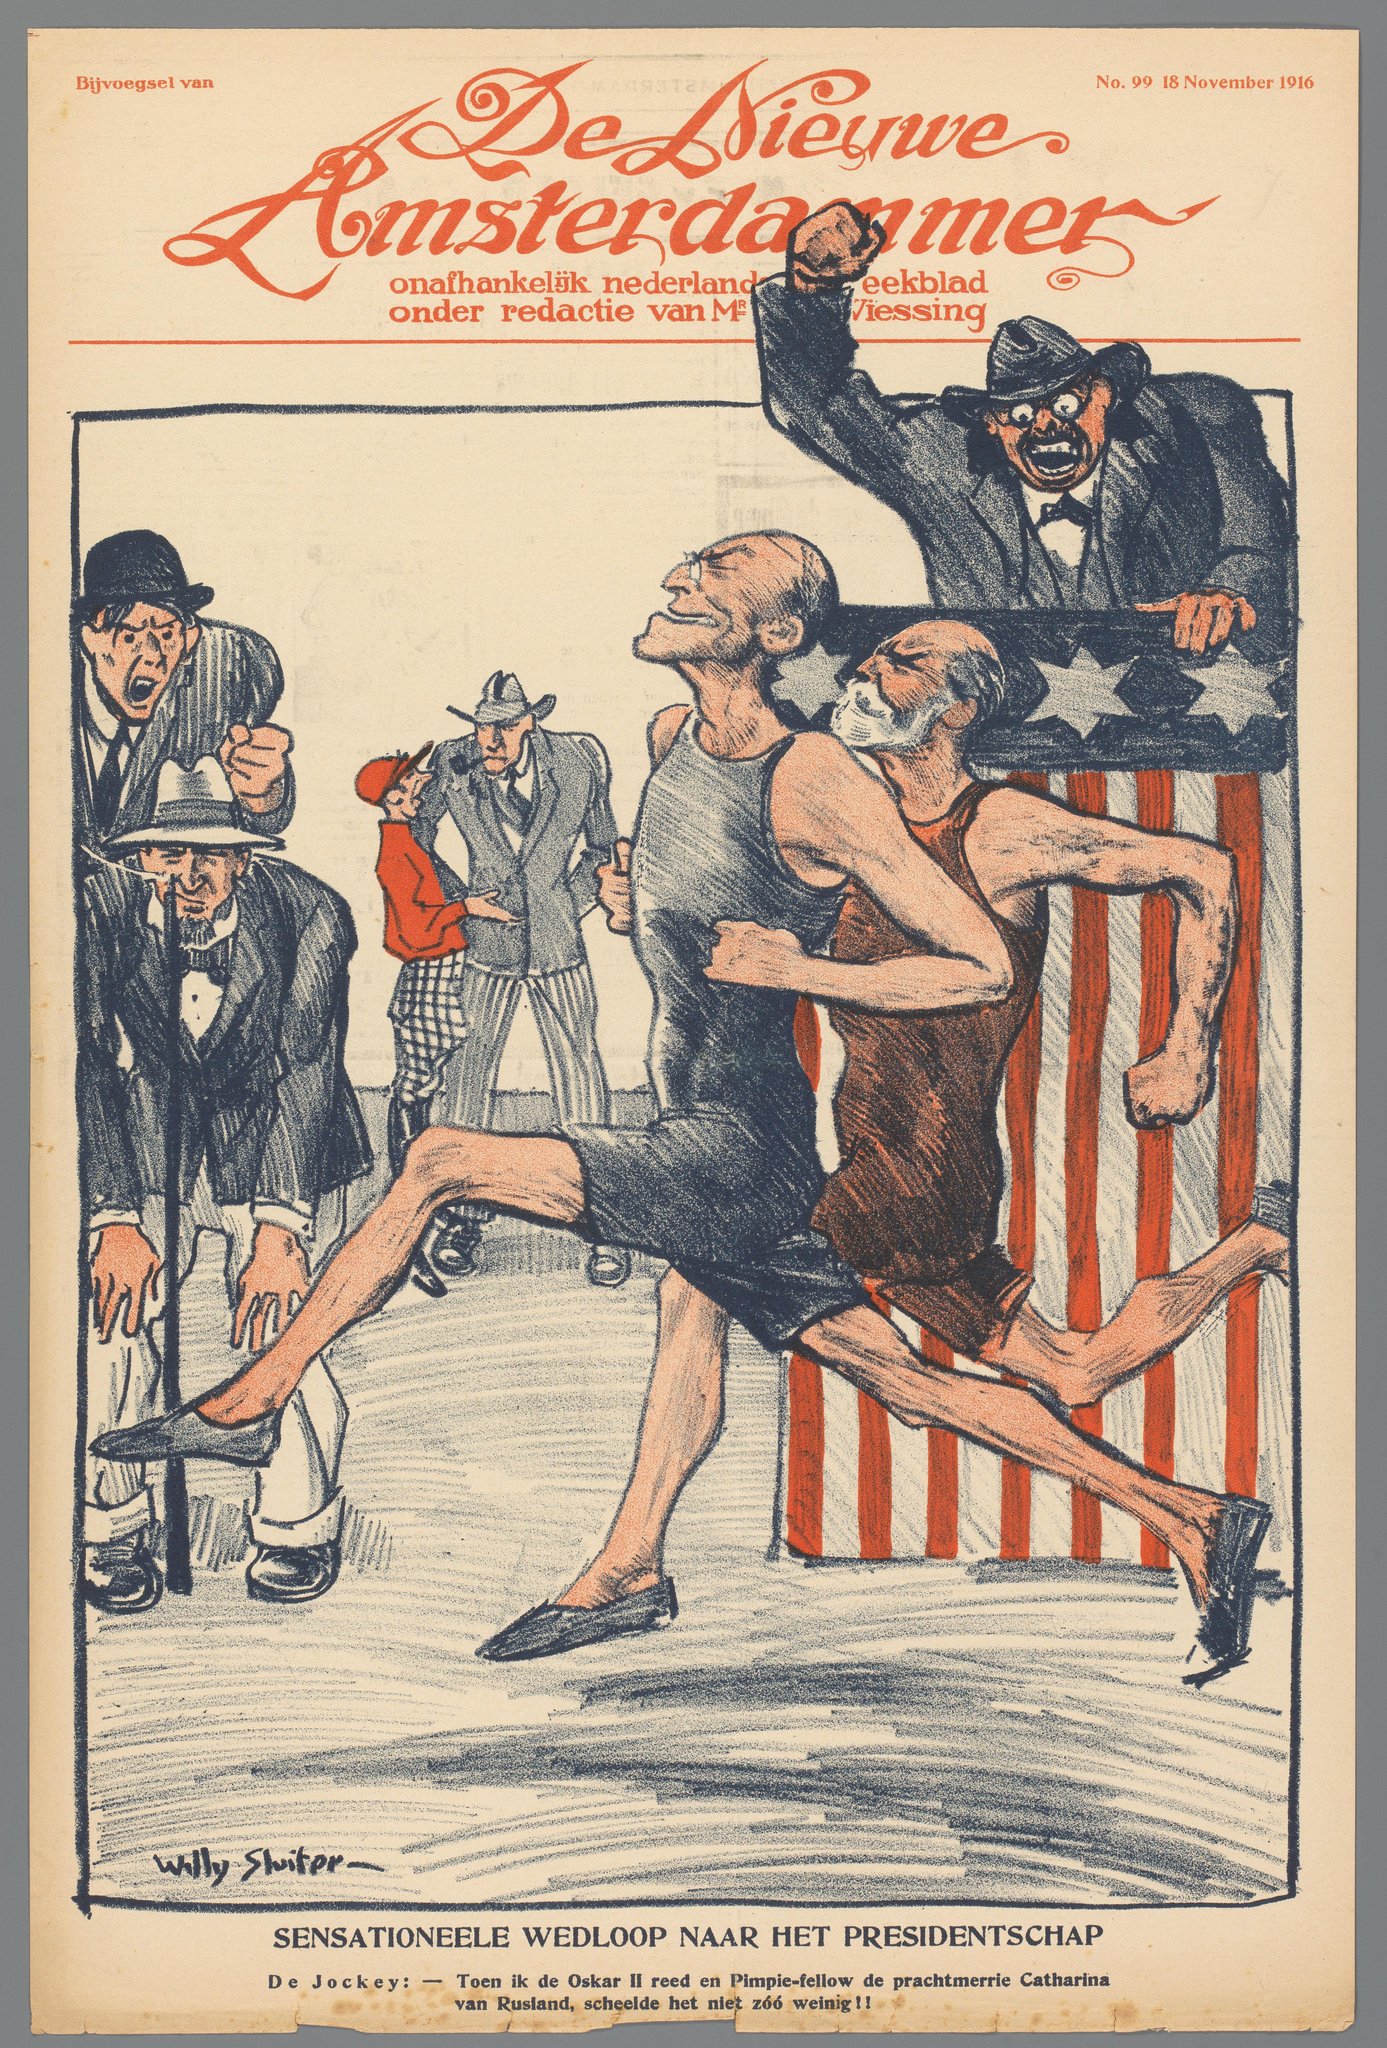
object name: print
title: Sensationeele wedloop naar het presidentschap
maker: willy sluiter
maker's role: draughtsman, painter, print maker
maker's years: 1873-1949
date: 1916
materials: paper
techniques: lithograph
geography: netherlands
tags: president ~ head of republic, running, race, horse-racing, political caricatures and satires, united states of america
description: De Amerikaanse strijd om het presidentschap tussen Woodrow Wilson en Charles Evans Hughes voorgesteld als een hardloopwedstrijd. Spotprent over buitenlandse politiek, 18 november 1916.